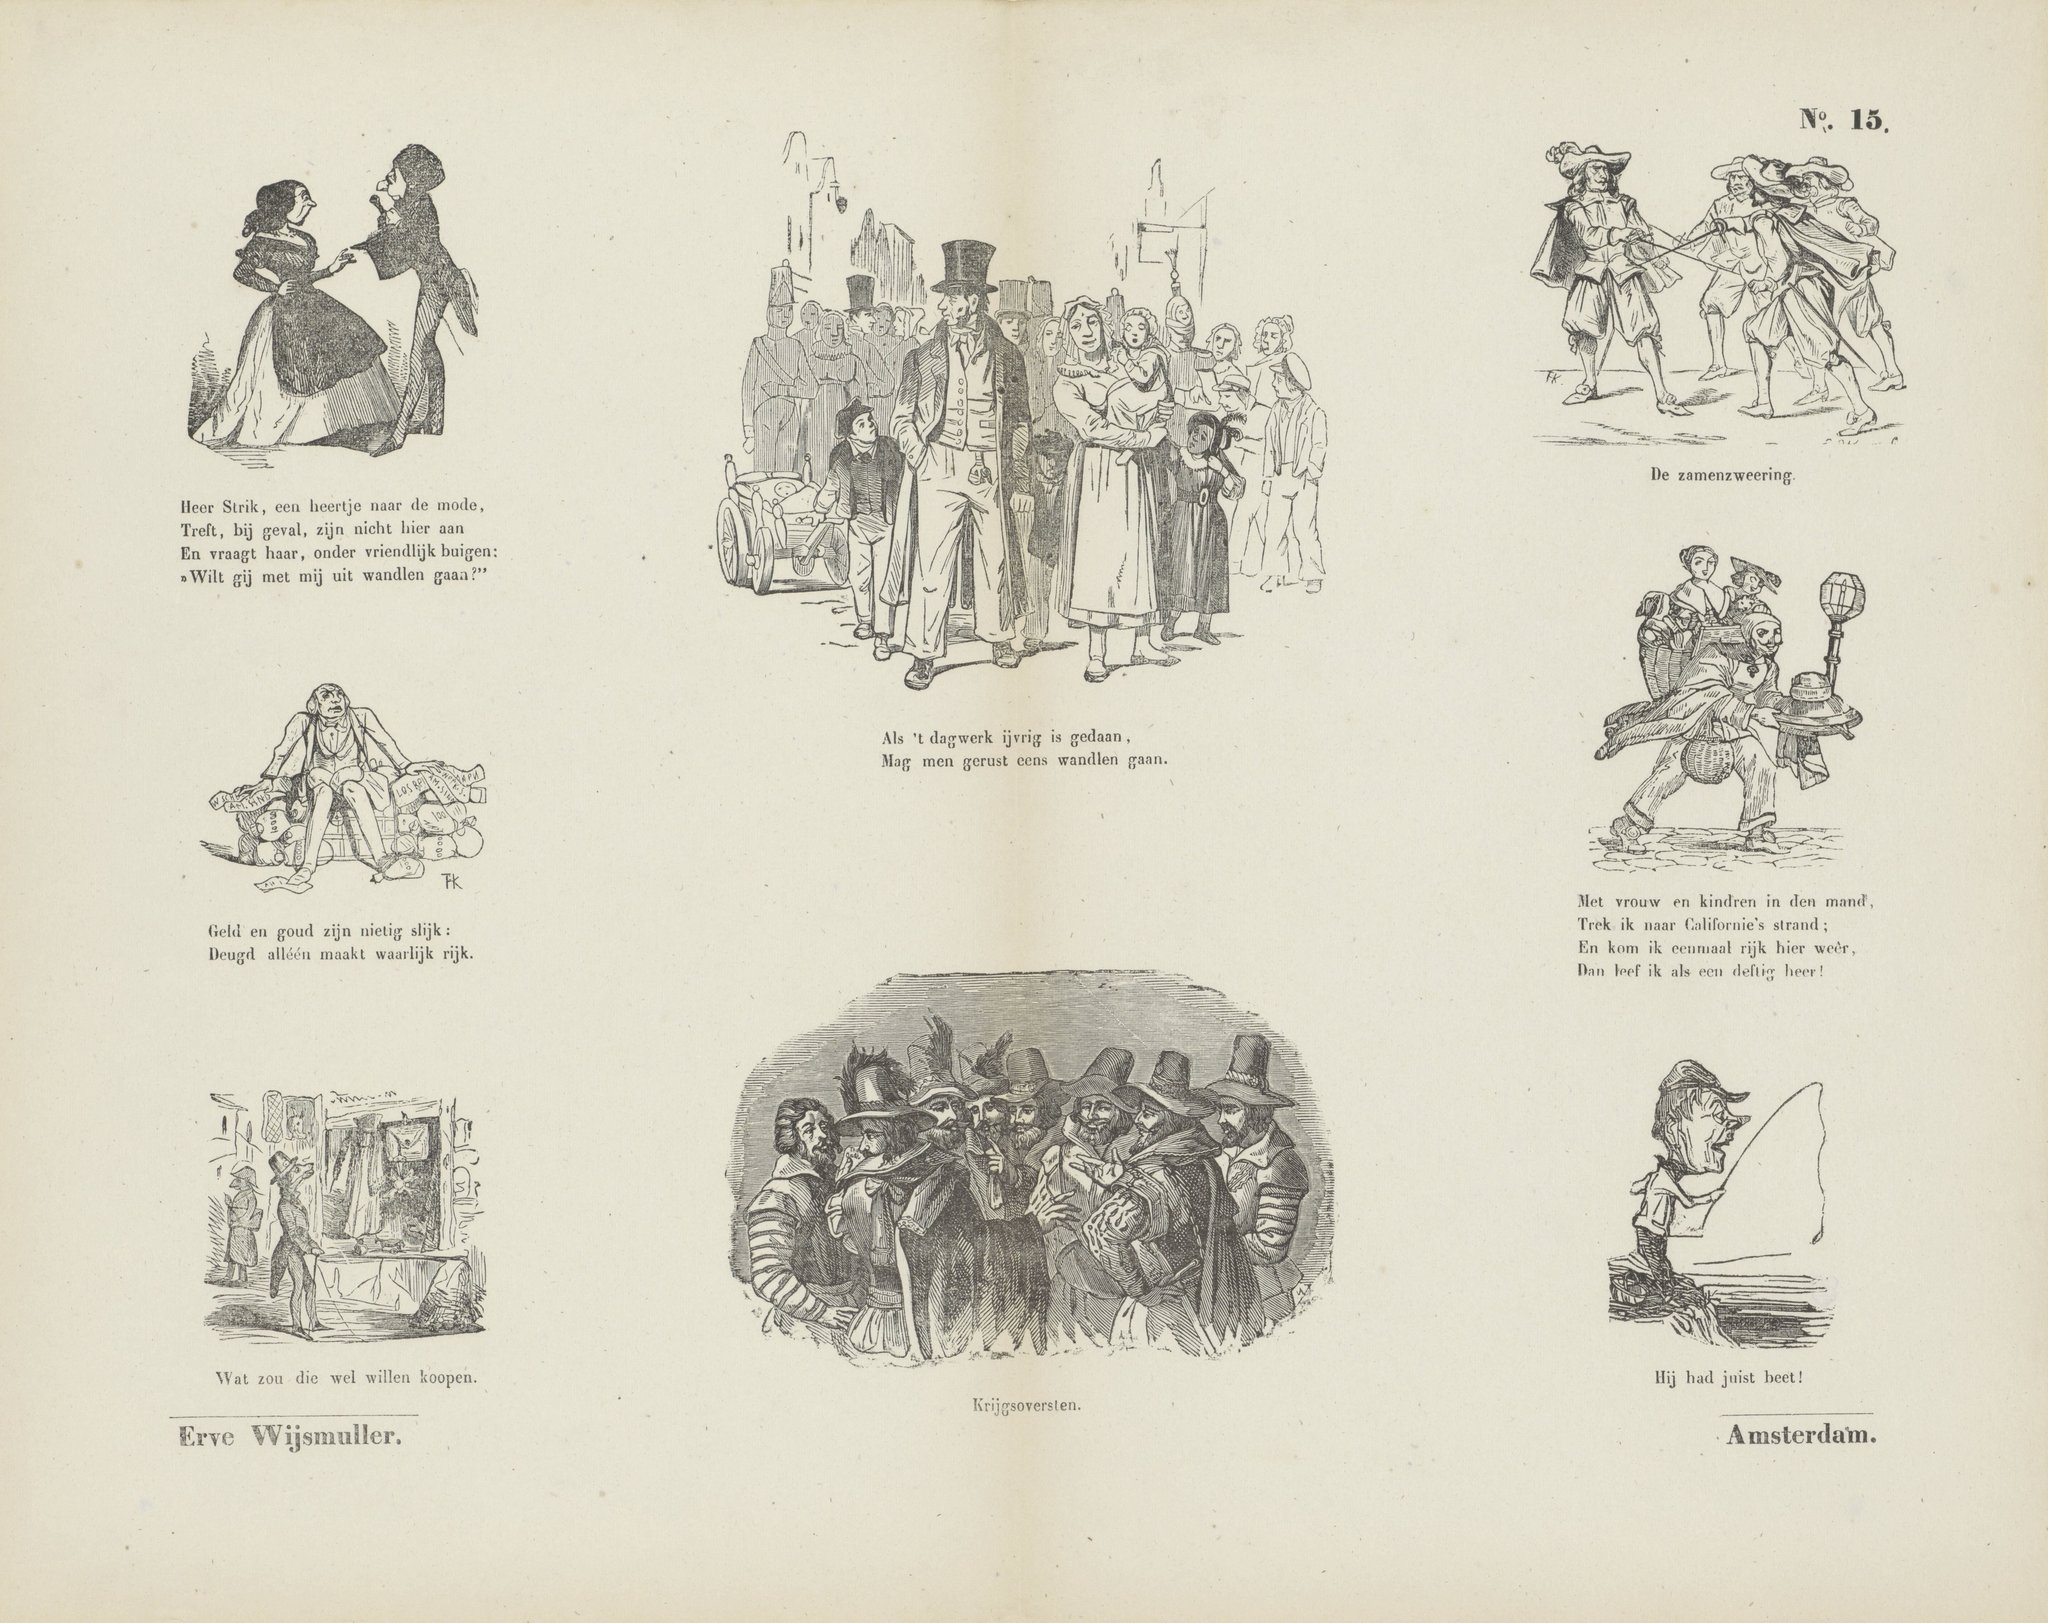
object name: print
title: Verschillende voorstellingen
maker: Anonymous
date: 1828-1913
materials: paper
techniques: letterpress printing, line block, engraving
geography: netherlands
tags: walking, hiking (recreation), characters (human types), fisherman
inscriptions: collector's mark: Lugt 2760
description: Blad met 8 voorstellingen van verschillende aard, waaronder allerlei figuren en bezigheden. Onder elke afbeelding een onderschrift. Onder de eerste afbeelding het onderschrift: Heer Strik, een heertje naar de mode... Genummerd rechtsboven: No. 15.